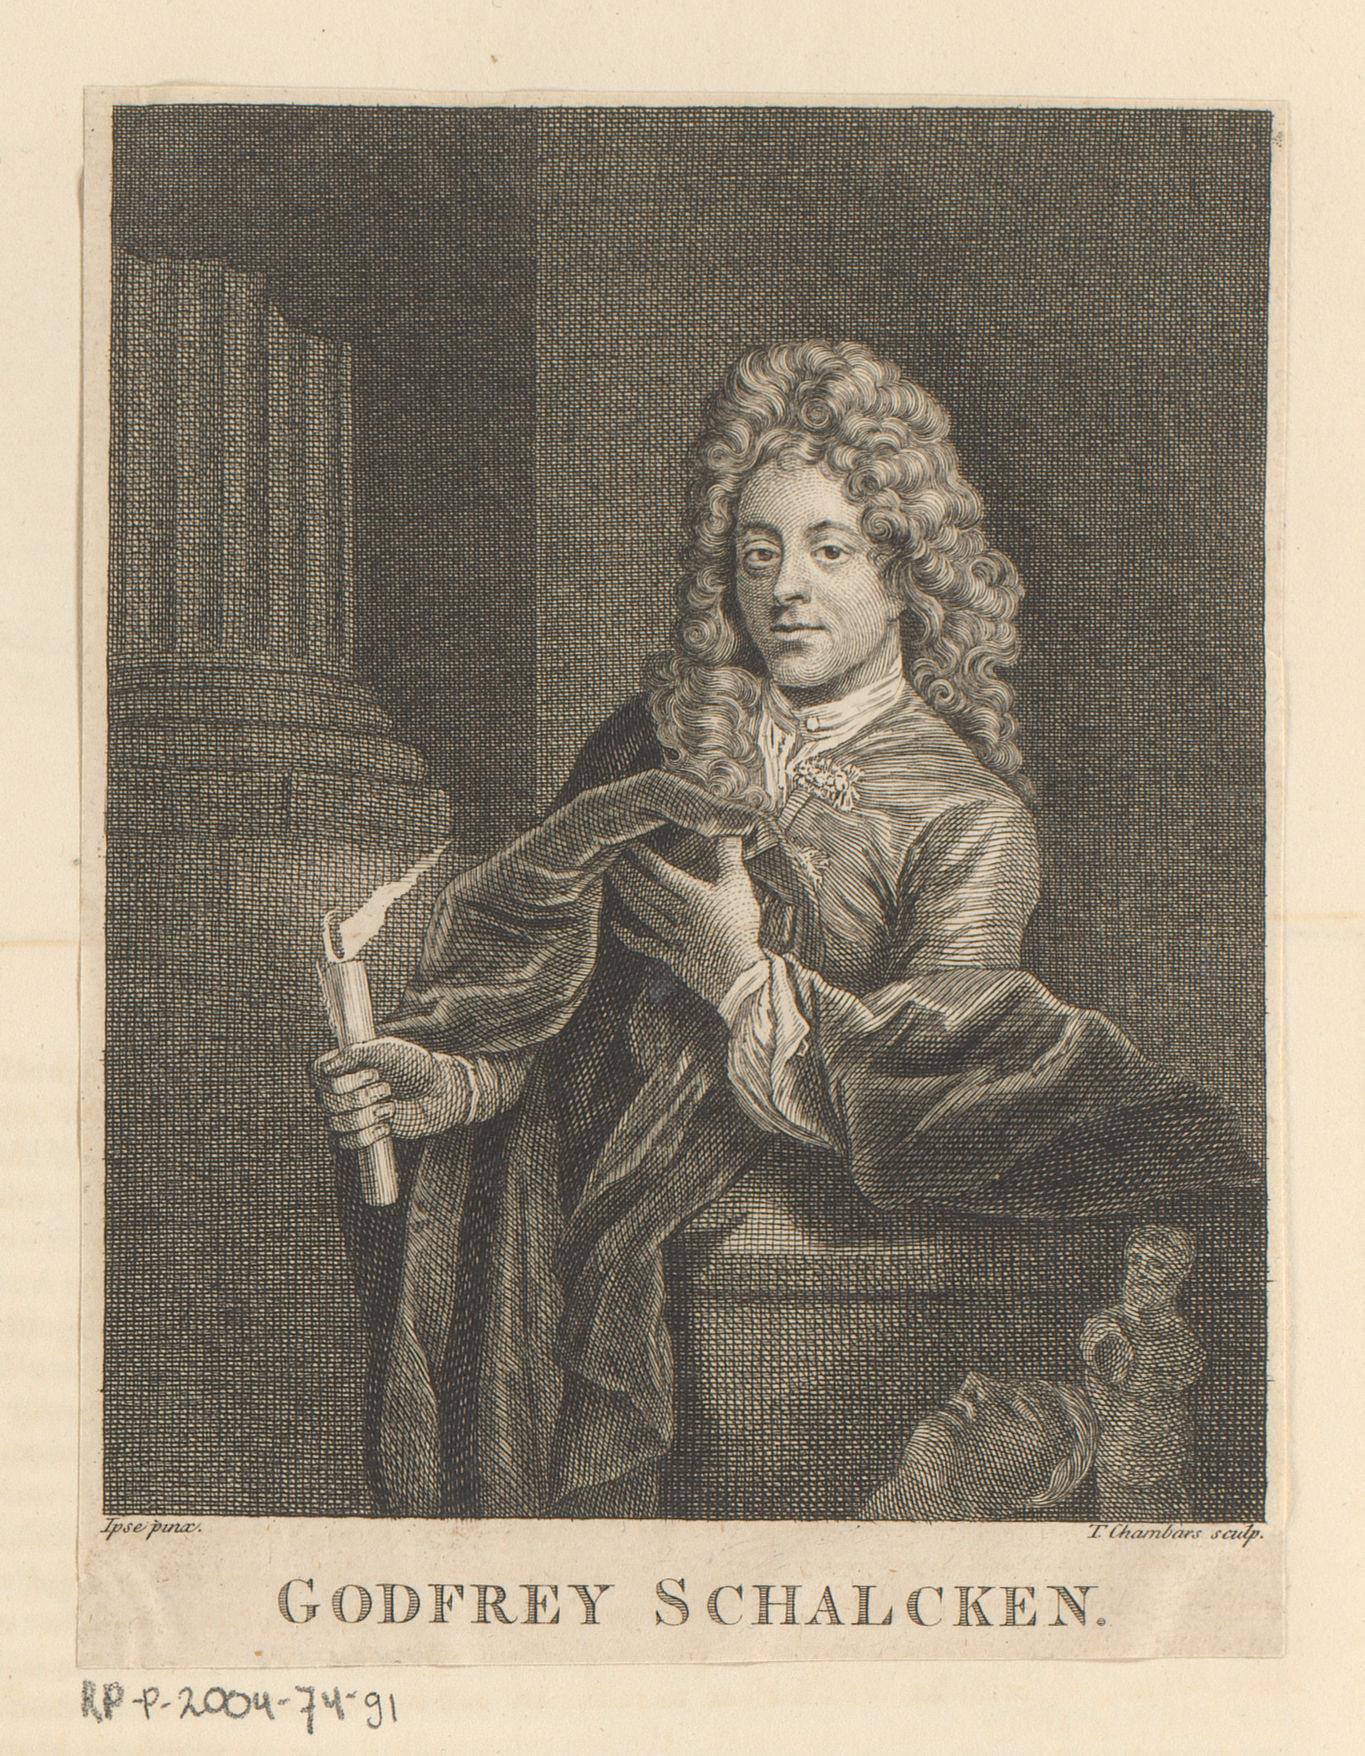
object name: print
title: Portret van Godfried Schalcken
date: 1762-1789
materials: paper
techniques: engraving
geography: london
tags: the hague, painter, print maker, draughtsman, godfried schalcken, historical persons, portrait, self-portrait of painter, candle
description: Prent uit: Walpole, Horace. Anecdotes of painting in England with some account of the principal artists and incidental notes on other arts collected by the late Mr. George Vertue and now digested and published from his original Mss. by Horace Walpole. 4 dln. Londen: Horace Walpole, [1762-1789], dl. 3, p. 13o. De samensteller heeft deze prent in het album geplakt als illustratie bij: Pilkington, Matthew en Johann Heinrich Füssli. A dictionary of painters, from the revival of the art to the present period. 4 dln. Londen: John Crowder, 1805, dl. 3, p. 502.